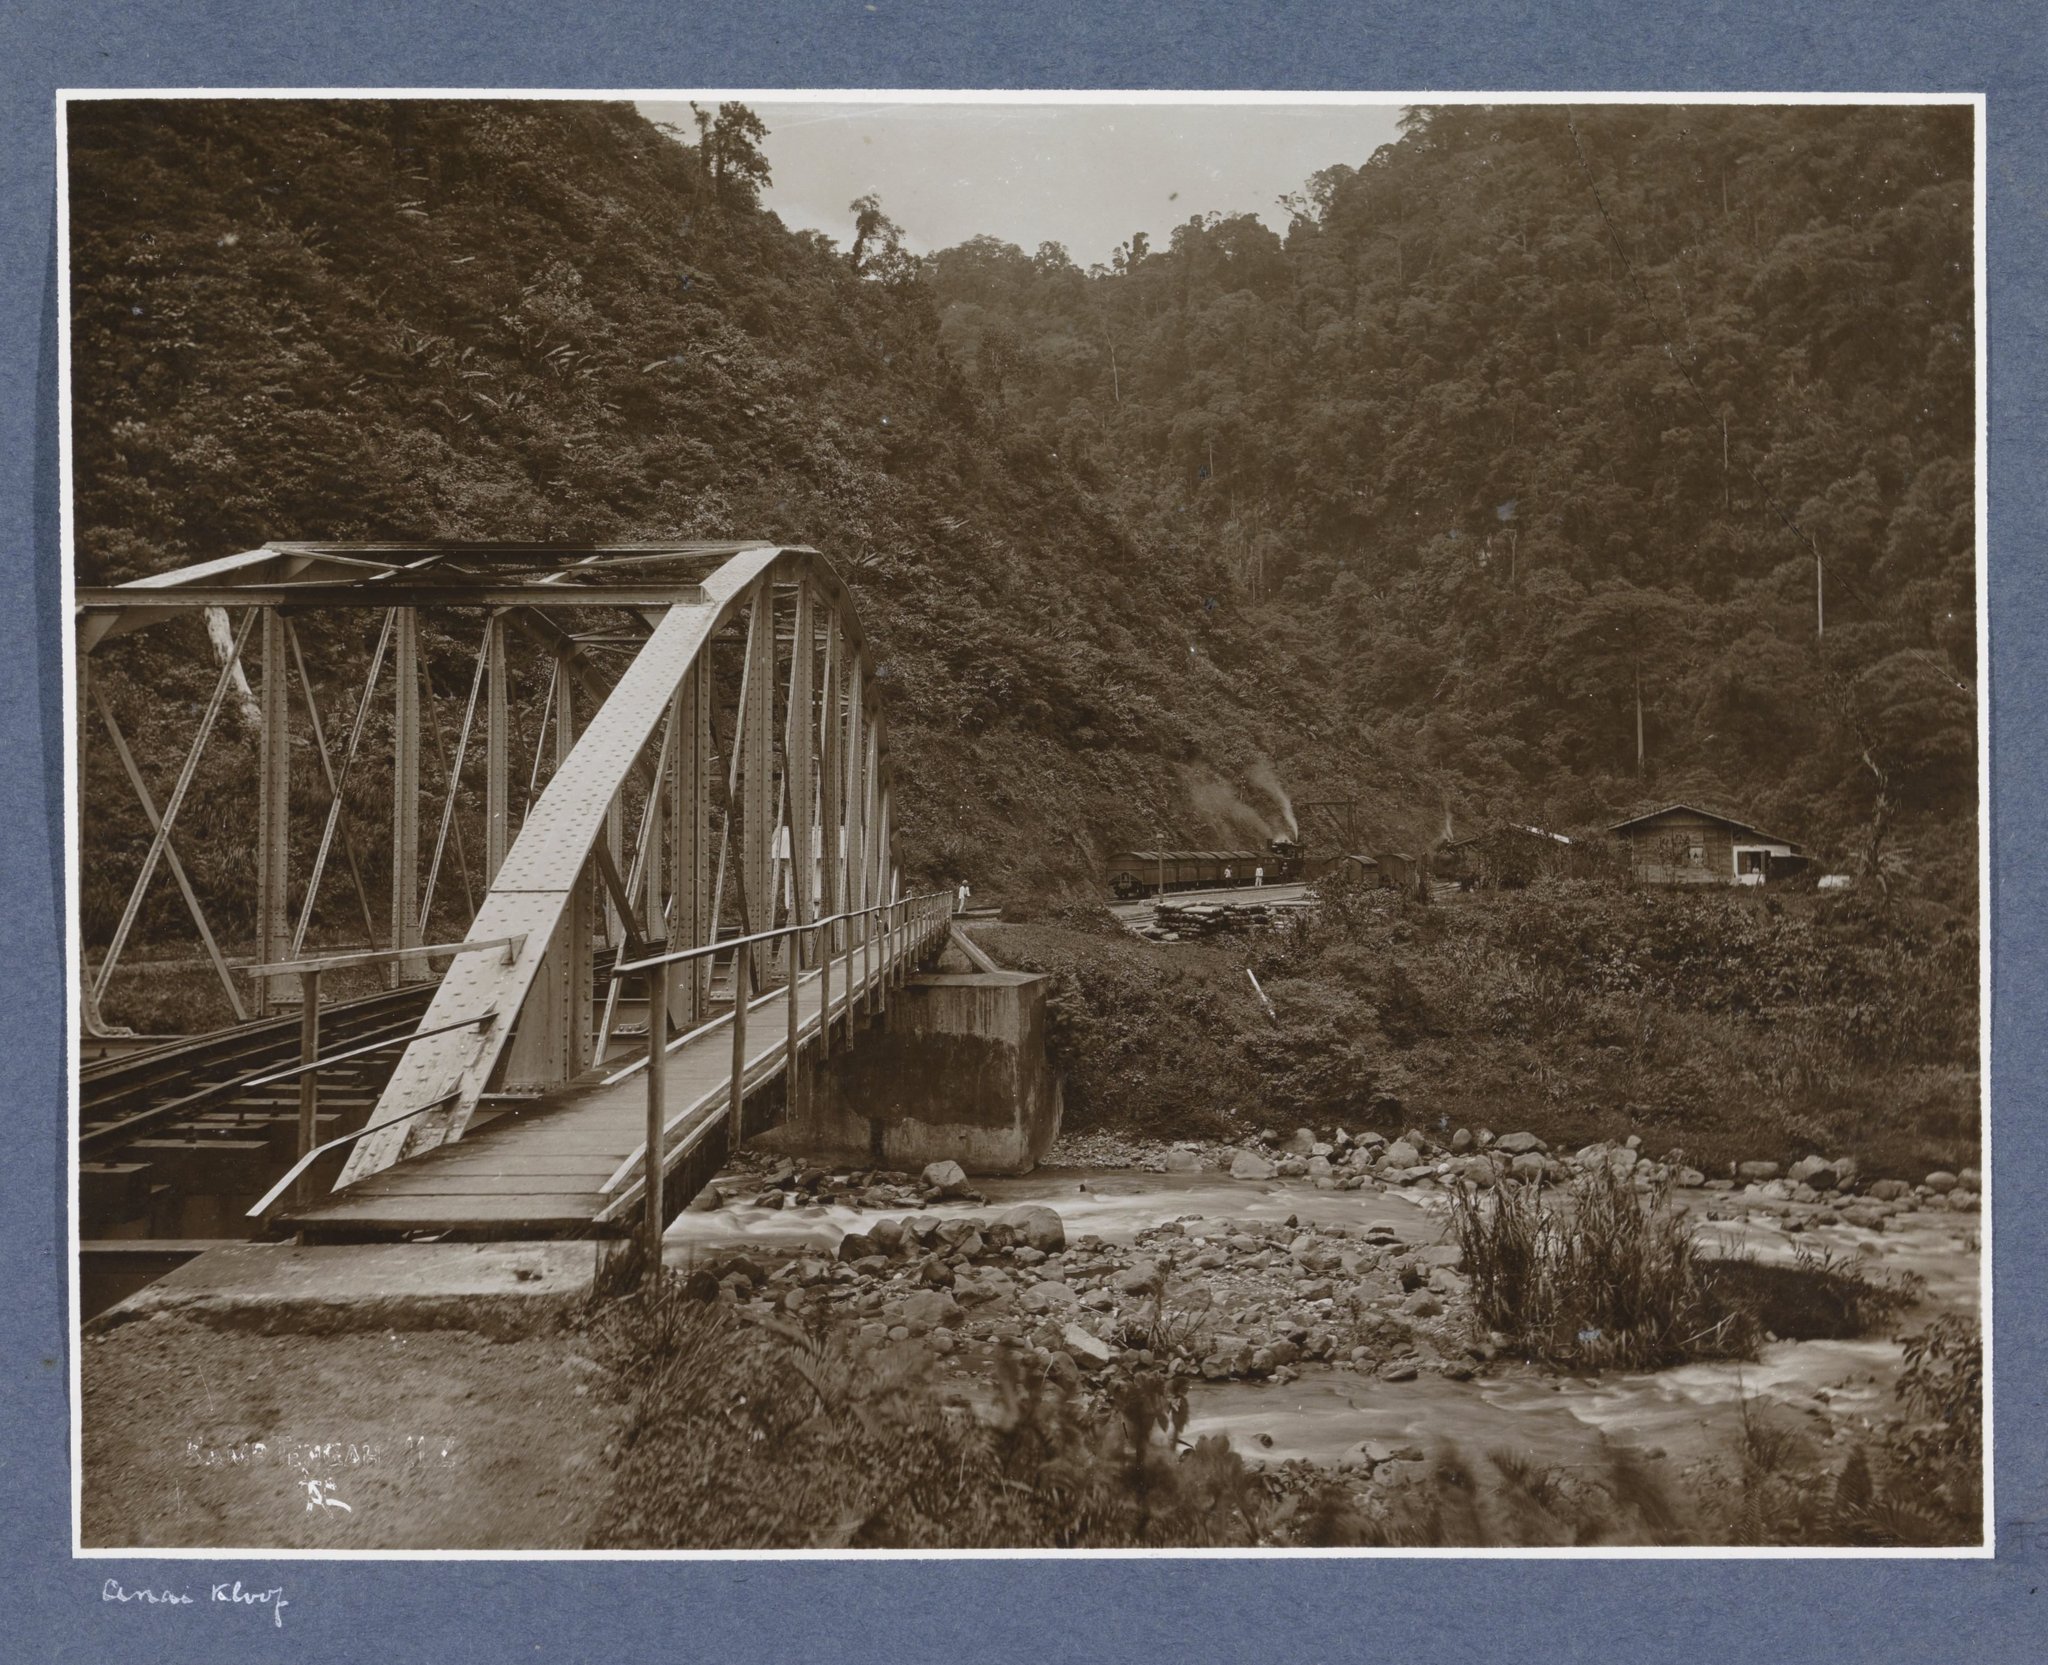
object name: photograph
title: Kamp Tengah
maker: christiaan benjamin nieuwenhuis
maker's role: publisher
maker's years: 1863-1922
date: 1900-1920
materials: paper, photographic support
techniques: gelatin silver print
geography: sumatra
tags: landscape with bridge, viaduct or aqueduct, railway, train, station; shelter (railway, tramway), sumatra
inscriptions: number: ‘11Z’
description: Onderdeel van reisalbum met foto's van bedrijvigheid en bezienswaardigheden op Sumatra en Java en van de reis naar en van Nederlands-Indië.